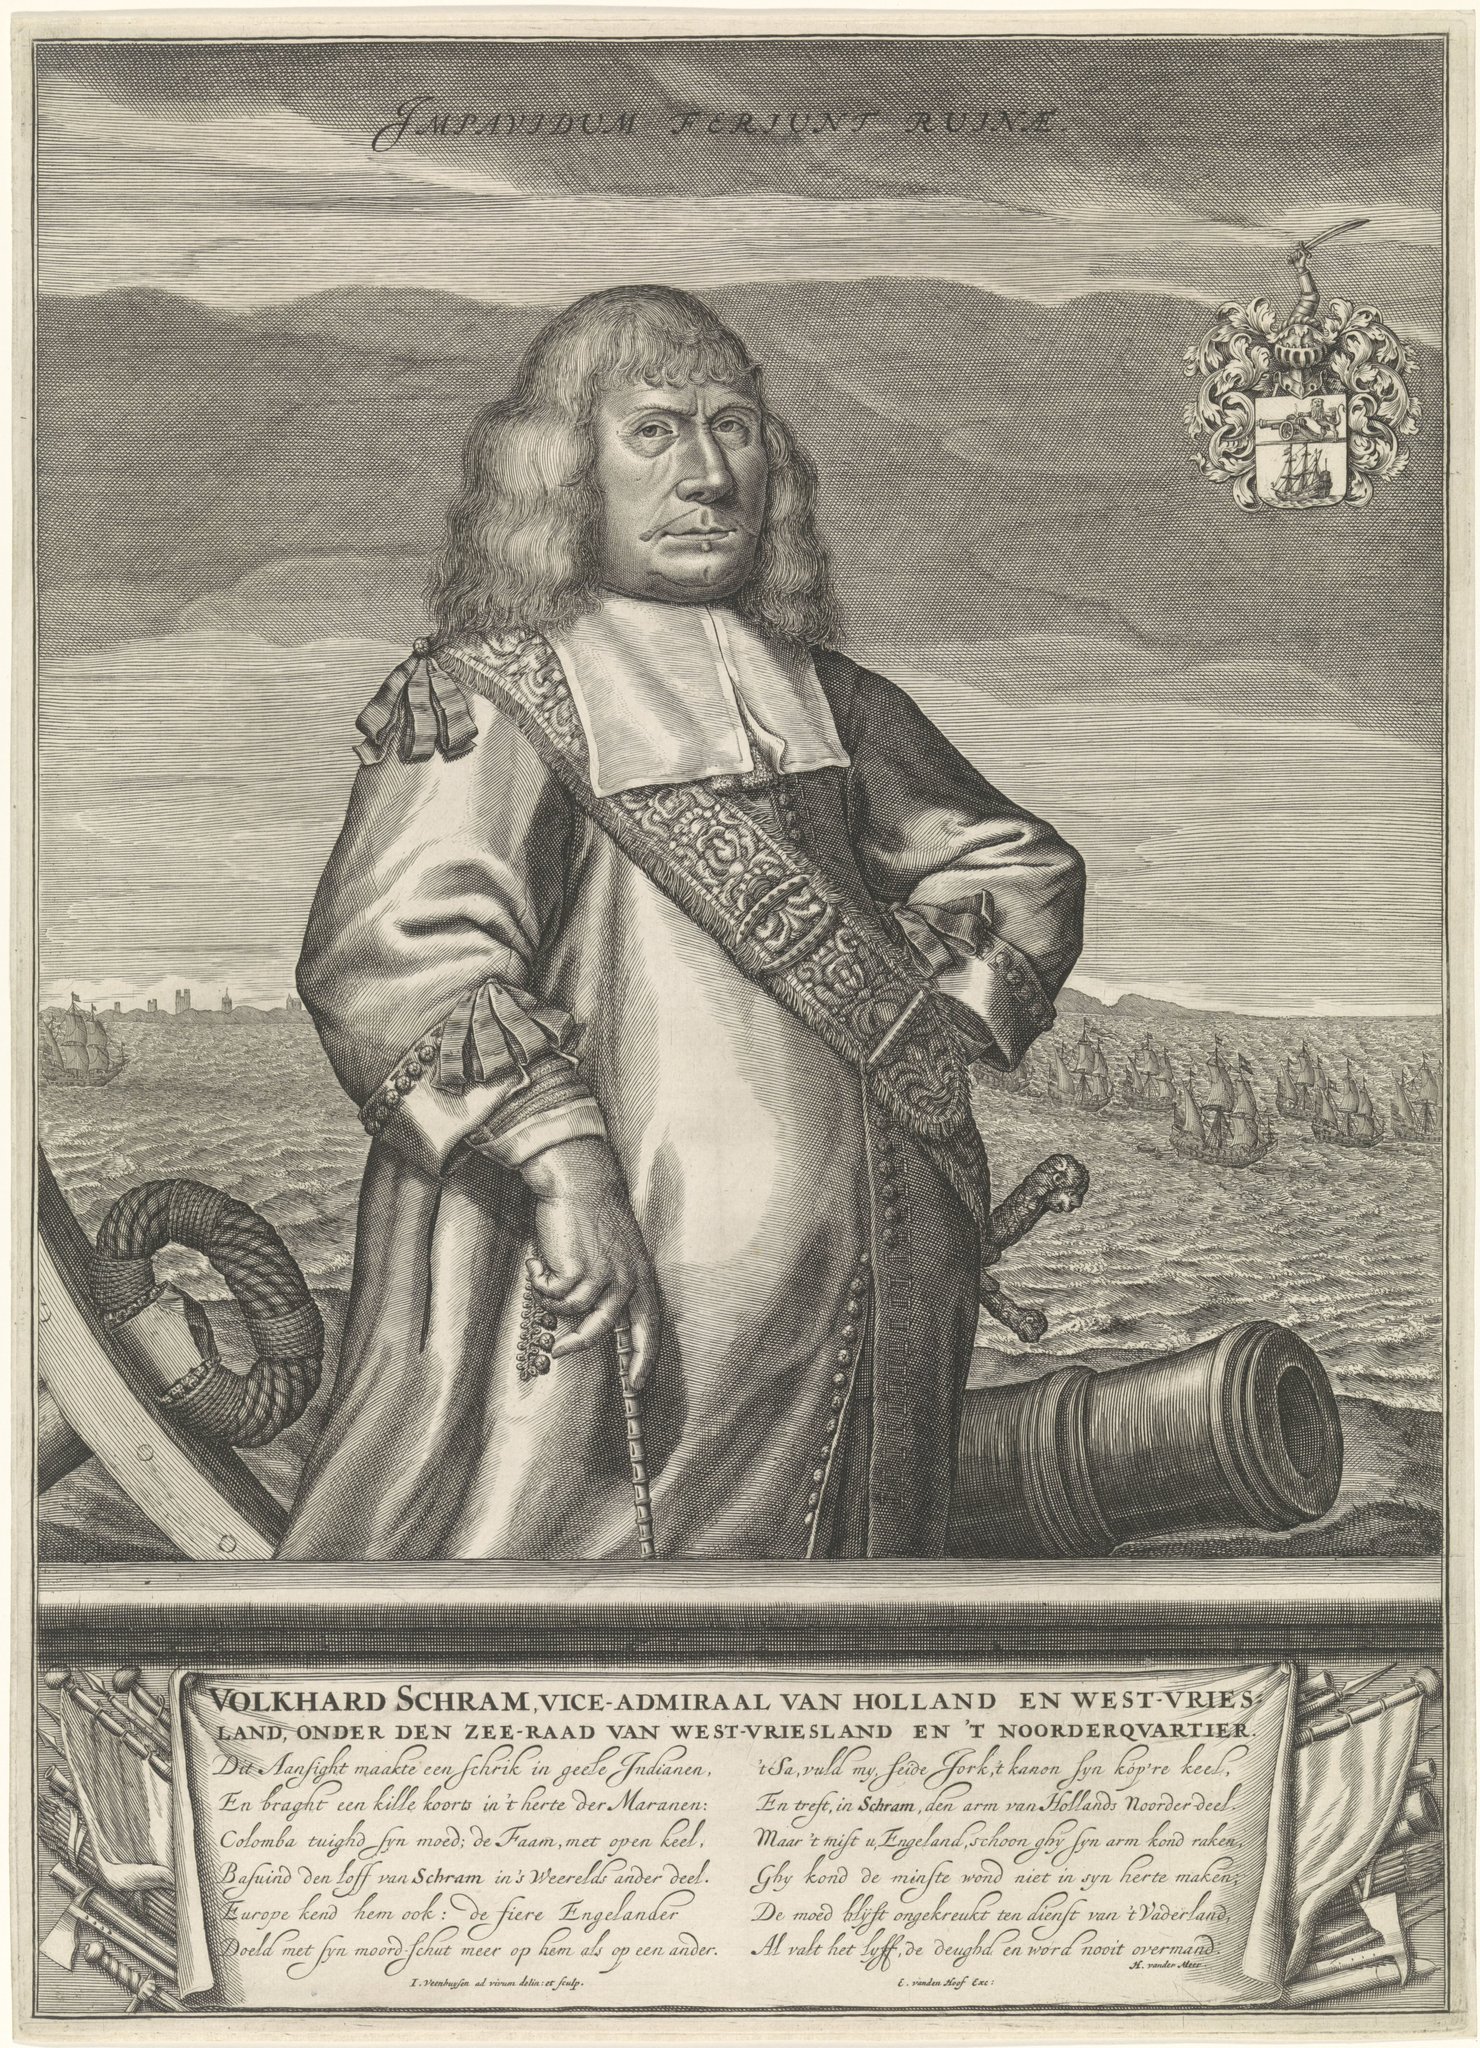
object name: print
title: Portret van Volkert Schram, Vice-admiraal van Holland en West-Friesland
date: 1655-1672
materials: paper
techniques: engraving, etching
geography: enkhuizen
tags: historical persons, ships (in general), firearms: cannon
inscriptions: collector's mark: Lugt 2760, collector's mark: Lugt 2228